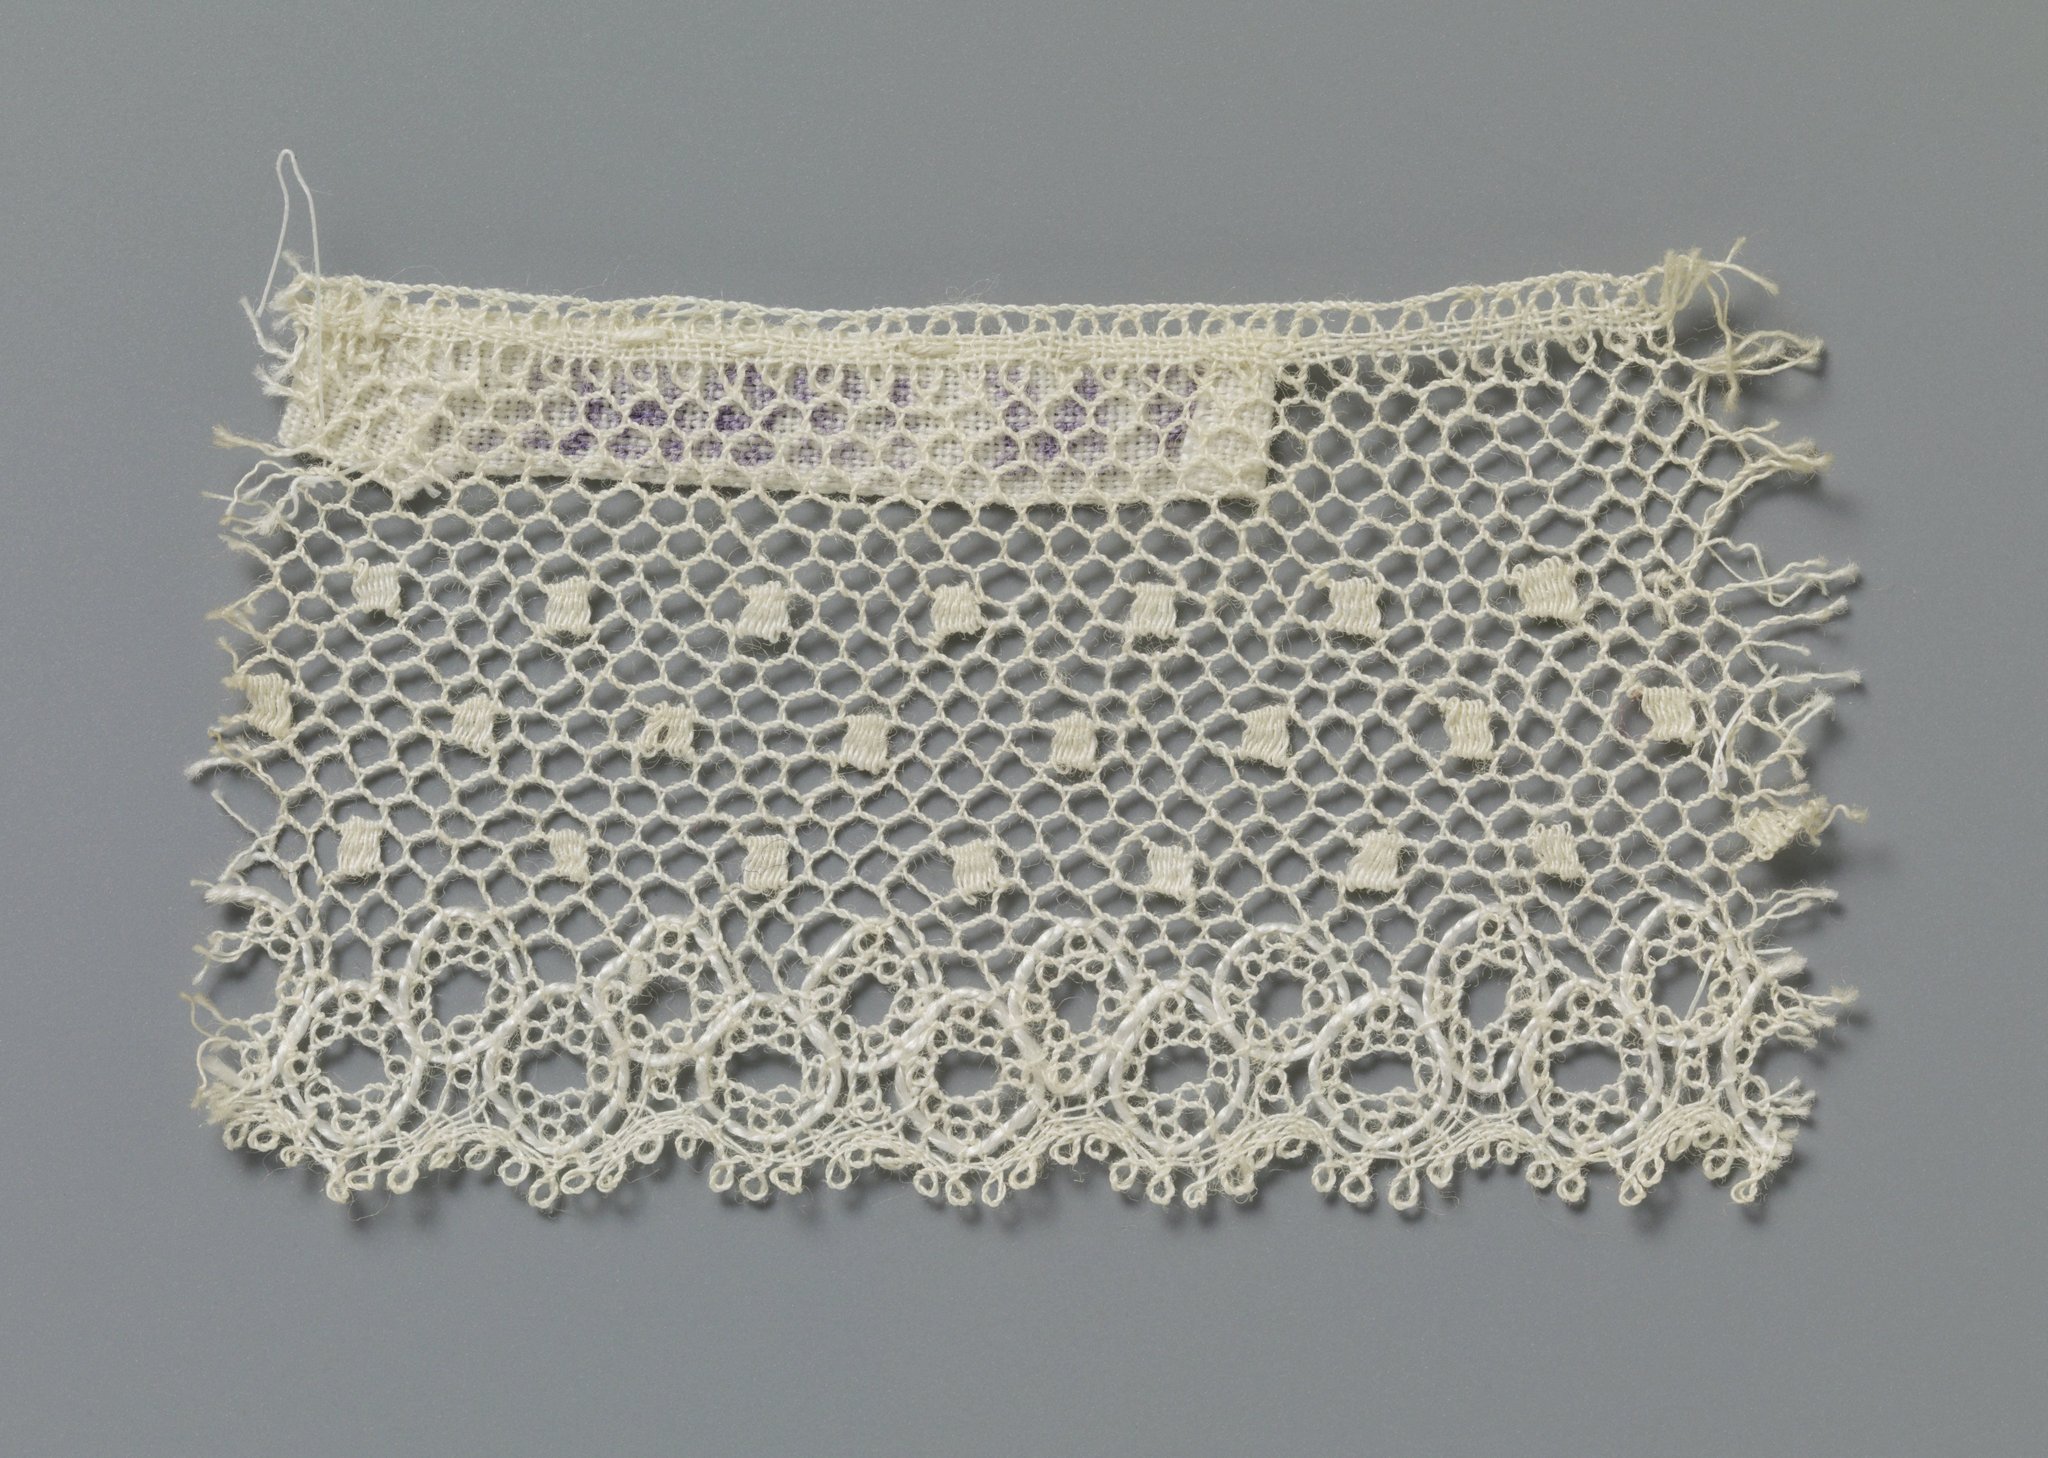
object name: strip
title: Strook kloskant met een smalle sierband langs de onderzijde van aaneengeschakelde cirkeltjes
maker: Anonymous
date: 1800-1899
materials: cotton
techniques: lace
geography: buckingham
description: Strook naturelkleurige kloskant, Buckingham-kant. Onder een strooipatroon van vierkante moesjes bestaat het patroon langs de onderzijde van de strook uit een smalle sierband, die wordt gevormd door een verspringende rij van aaneengeschakelde cirkeltjes. De strook bestaat grotendeels uit een maasgrond, een tulegrond. De cirkeltjes zelf zijn met dikke en glimmende contourdraden gemaakt rond de mazen van een siergrond, een rozengrond. De moesjes zijn gemaakt in vormslag. De bovenzijde van de strook is recht afgewerkt. De zeer flauwe schulpenrand langs de onderzijde komt voort uit het patroon met de cirkeltjes en is afgewerkt met picots.